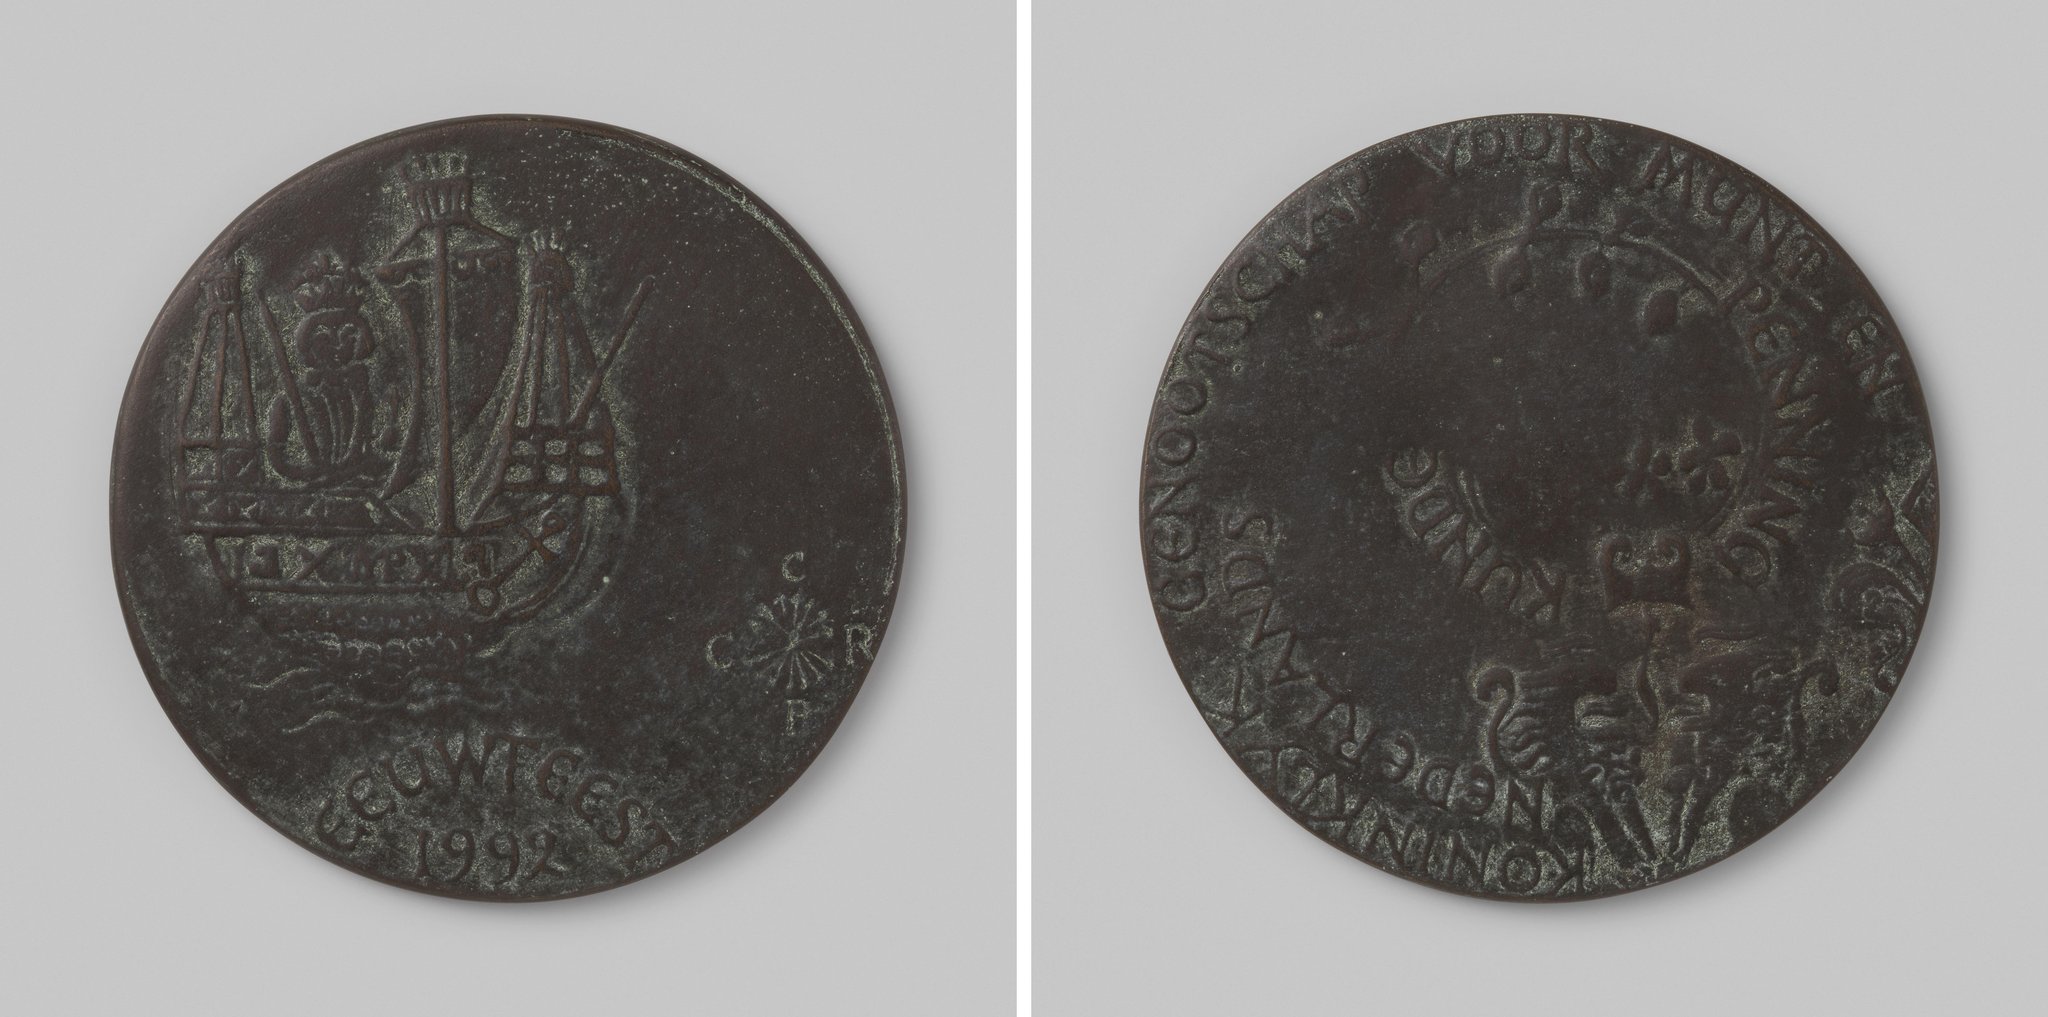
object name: history medal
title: Eeuwfeest Koninklijk Genootschap voor Munt en Penningkunde, 1992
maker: Anonymous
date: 1992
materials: bronze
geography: netherlands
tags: koninklijk nederlands genootschap voor munt- en penningkunde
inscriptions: inscription: ‘KONINKLYK NEDERALANDS GENOOTSCHAP VOOR MUNT EN PENNINGKUNDE’, caption: ‘EEUWFEEST 1992’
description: Bronzen plaquette van het eeuwfeest van het Koninklijk Genootschap voor Munt en Penningkunde, 1992. Voorzijde: schip met onderschrift. Keerzijde: opschrift.